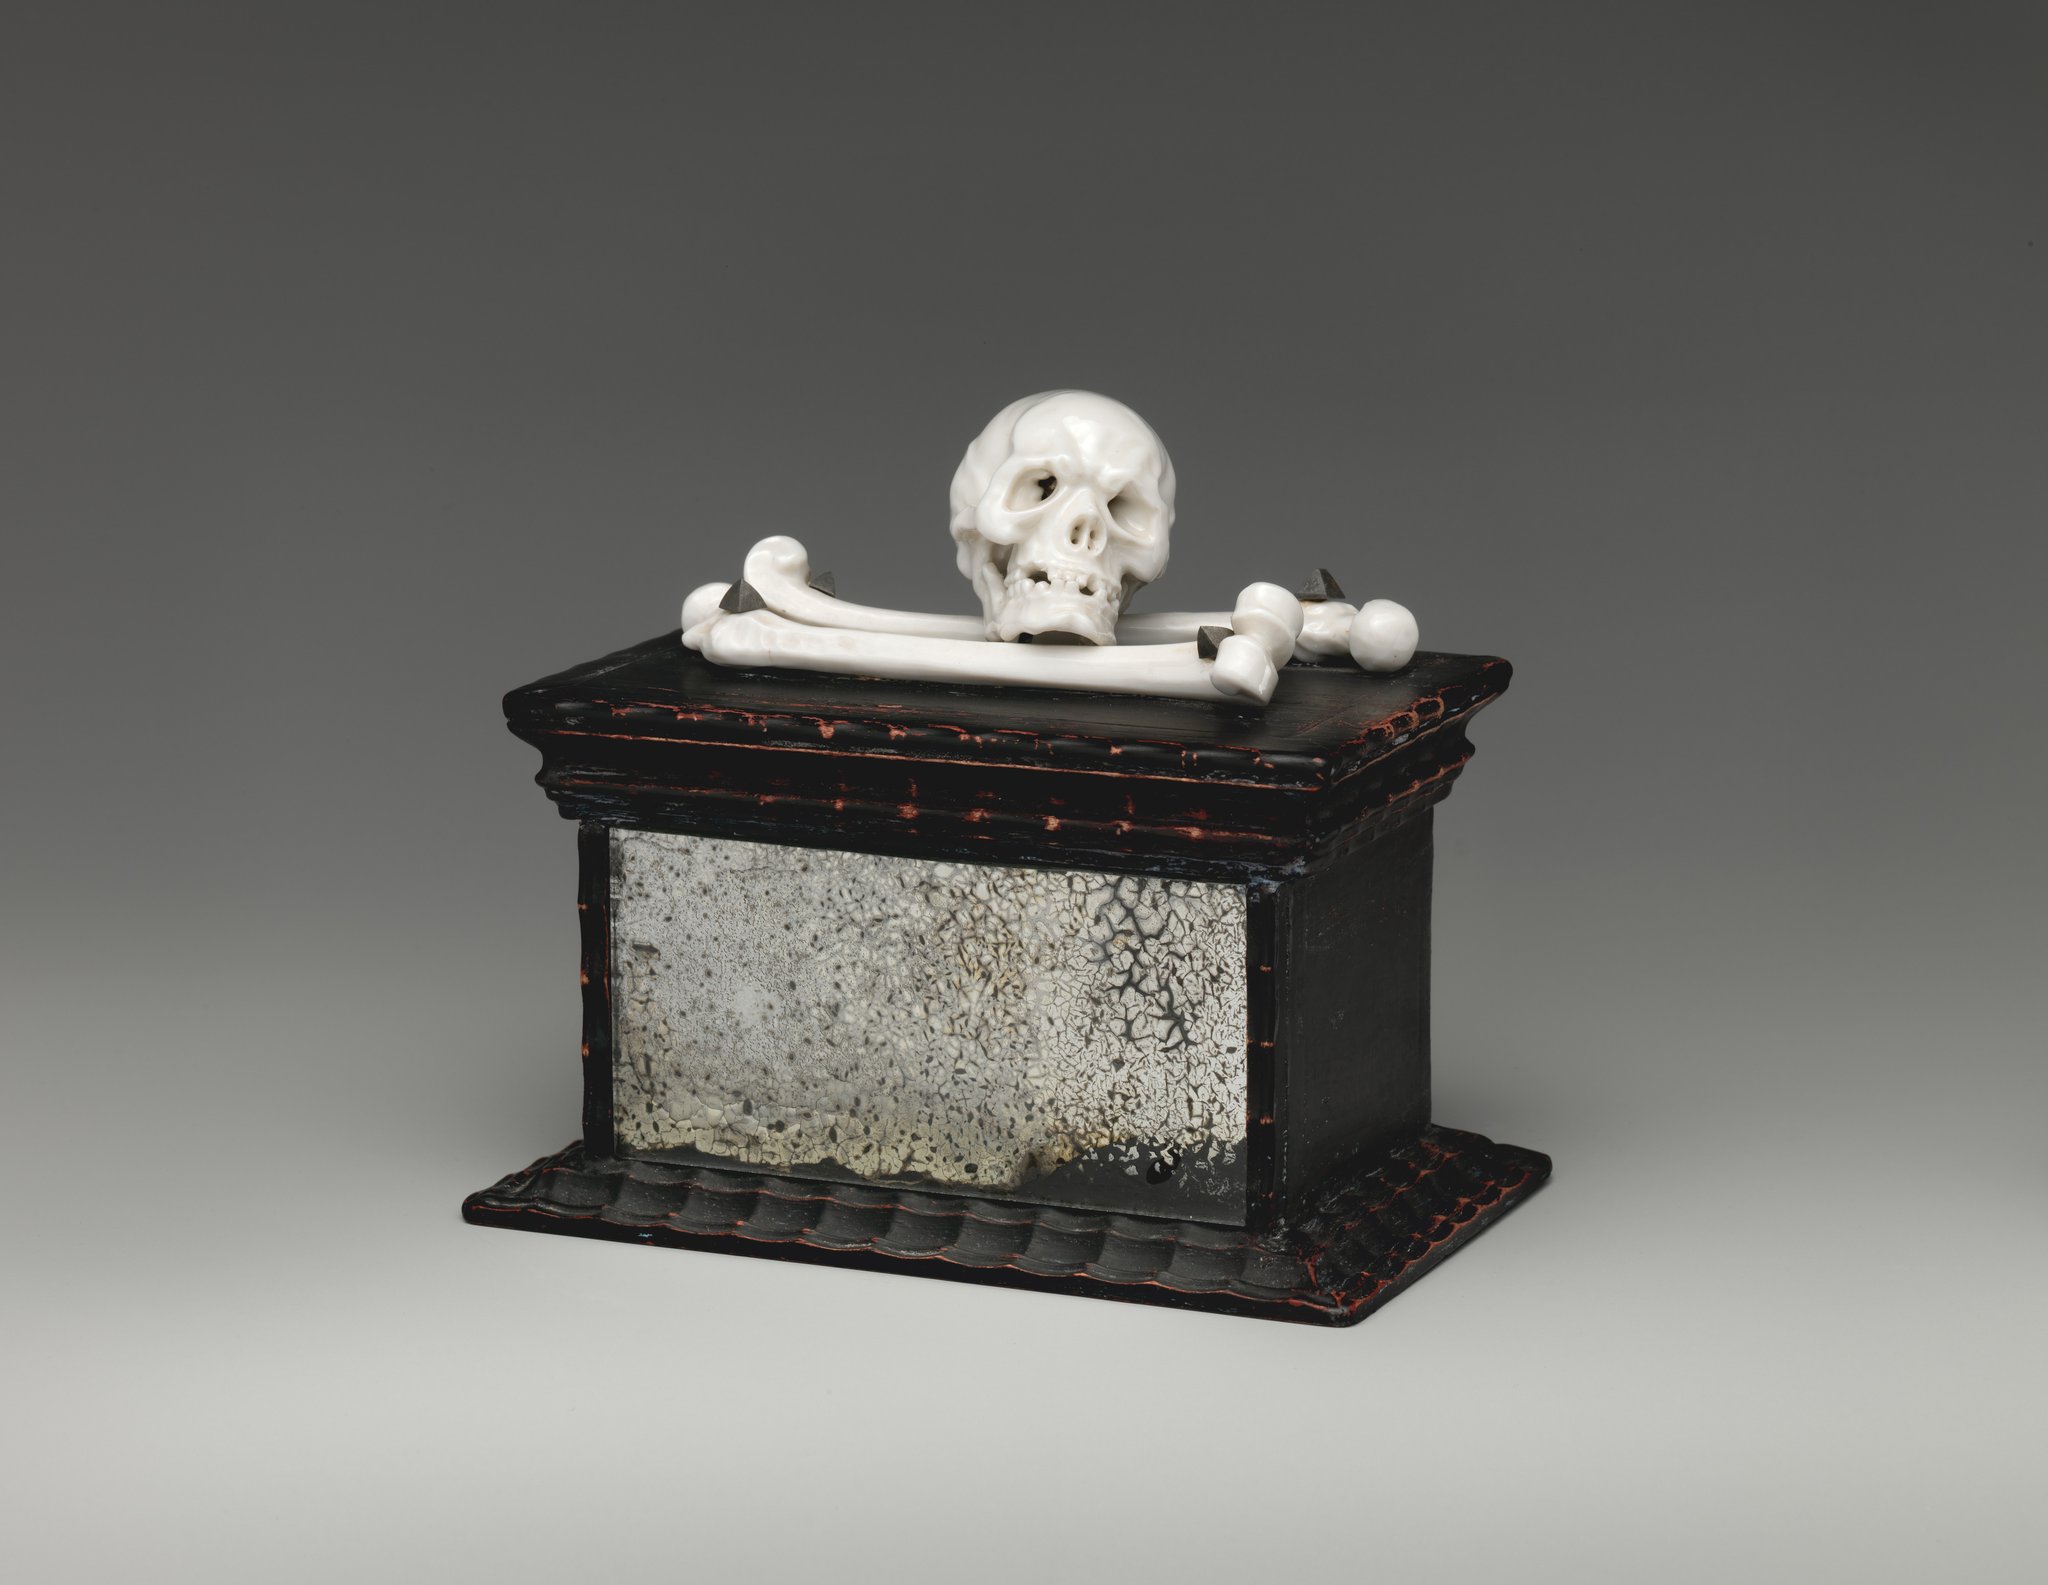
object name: skull and crossbones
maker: nymphenburg porcelain manufactory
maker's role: manufactory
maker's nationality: german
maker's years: 1747-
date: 1755-1760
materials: glass, hard paste porcelain, metal, wood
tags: skulls